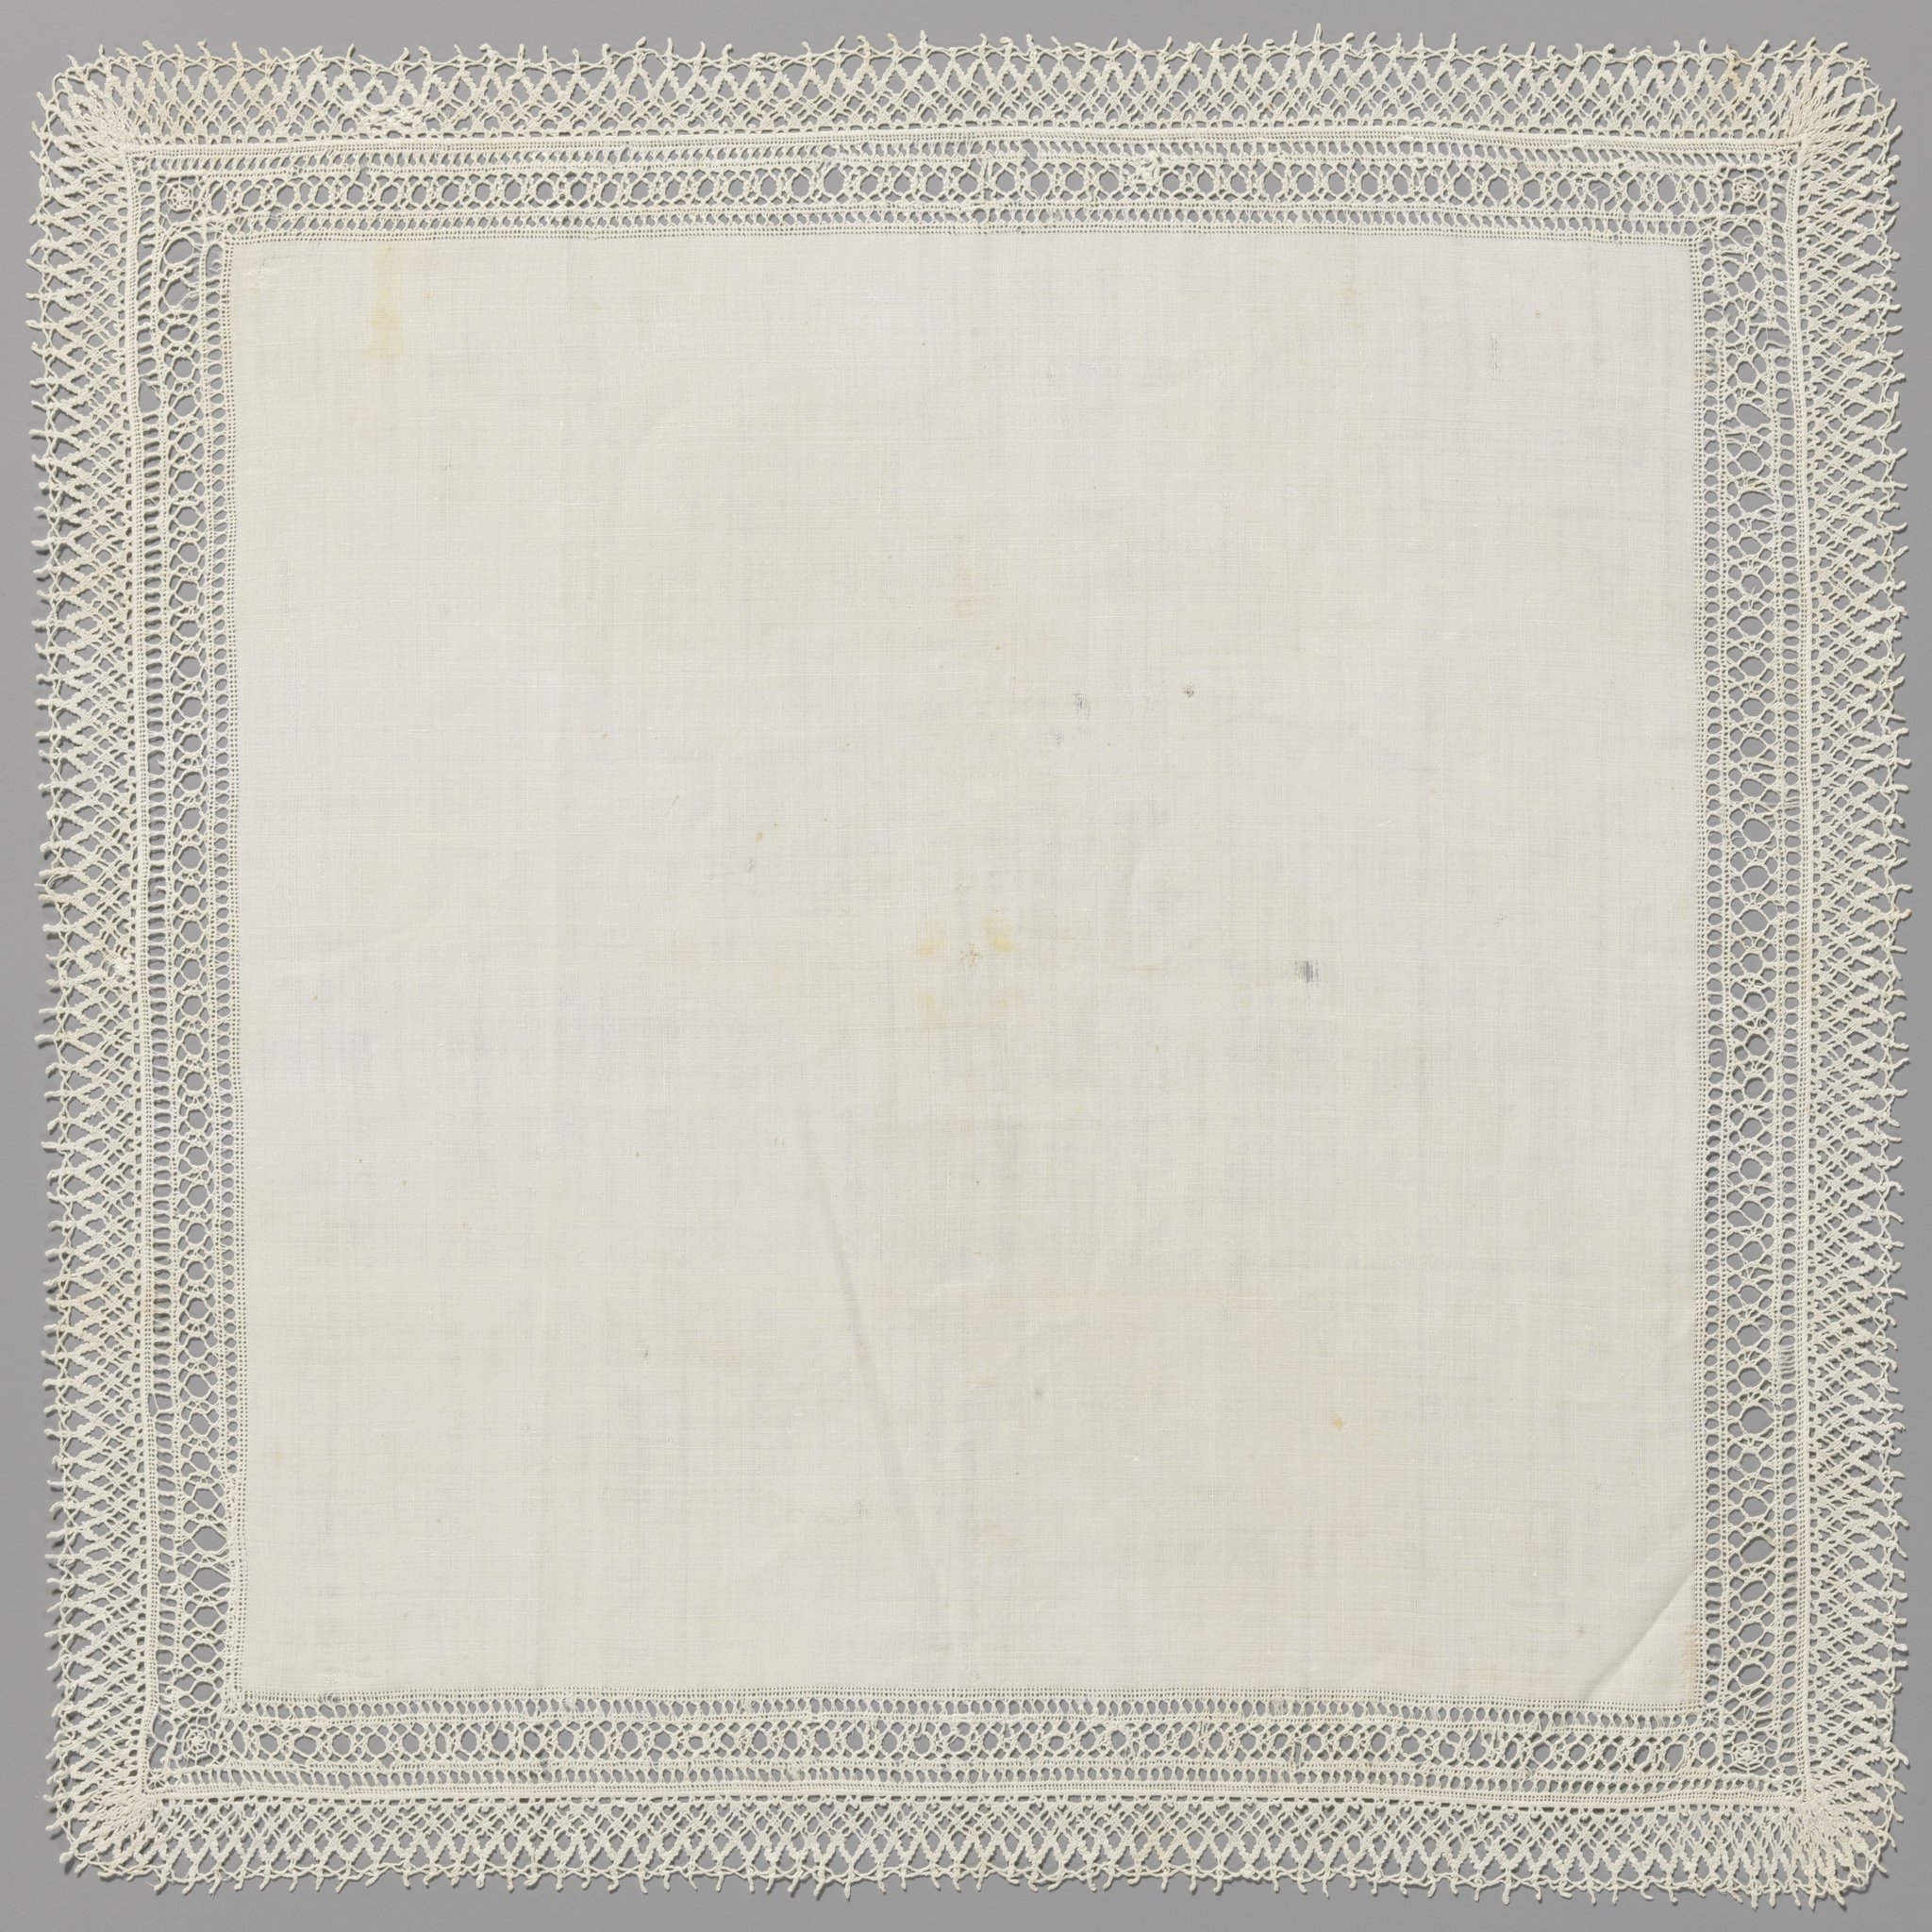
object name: purificator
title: Kelkdoek of velum van linnen met rondom een rand kantborduurwerk en een rand kloskant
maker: Anonymous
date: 1600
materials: linen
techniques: lace, weave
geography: netherlands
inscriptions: mark: ‘+’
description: Kelkdoek of velum van linnen met rondom een rand naturelkleurig kantborduurwerk: werk met uitgetrokken draden (open naaiwerk). Het geheel is rondom afgewerkt met een rand naturelkleurig kloskant. Vierkant model met afgeronde hoeken. Het werk met uitgetrokken draden heeft tussen twee smalle banen met opengewerkte ovaaltjes een bredere baan met grotere opengewerkte ovalen en op elke hoekpunt een wiel. Het kloskant bestaat uit een netwerk van ruitjes waarbij de buitenrand eindigt in een zigzag-lijn met daarlangs een picotrand van fijne gevlochtte puntjes.